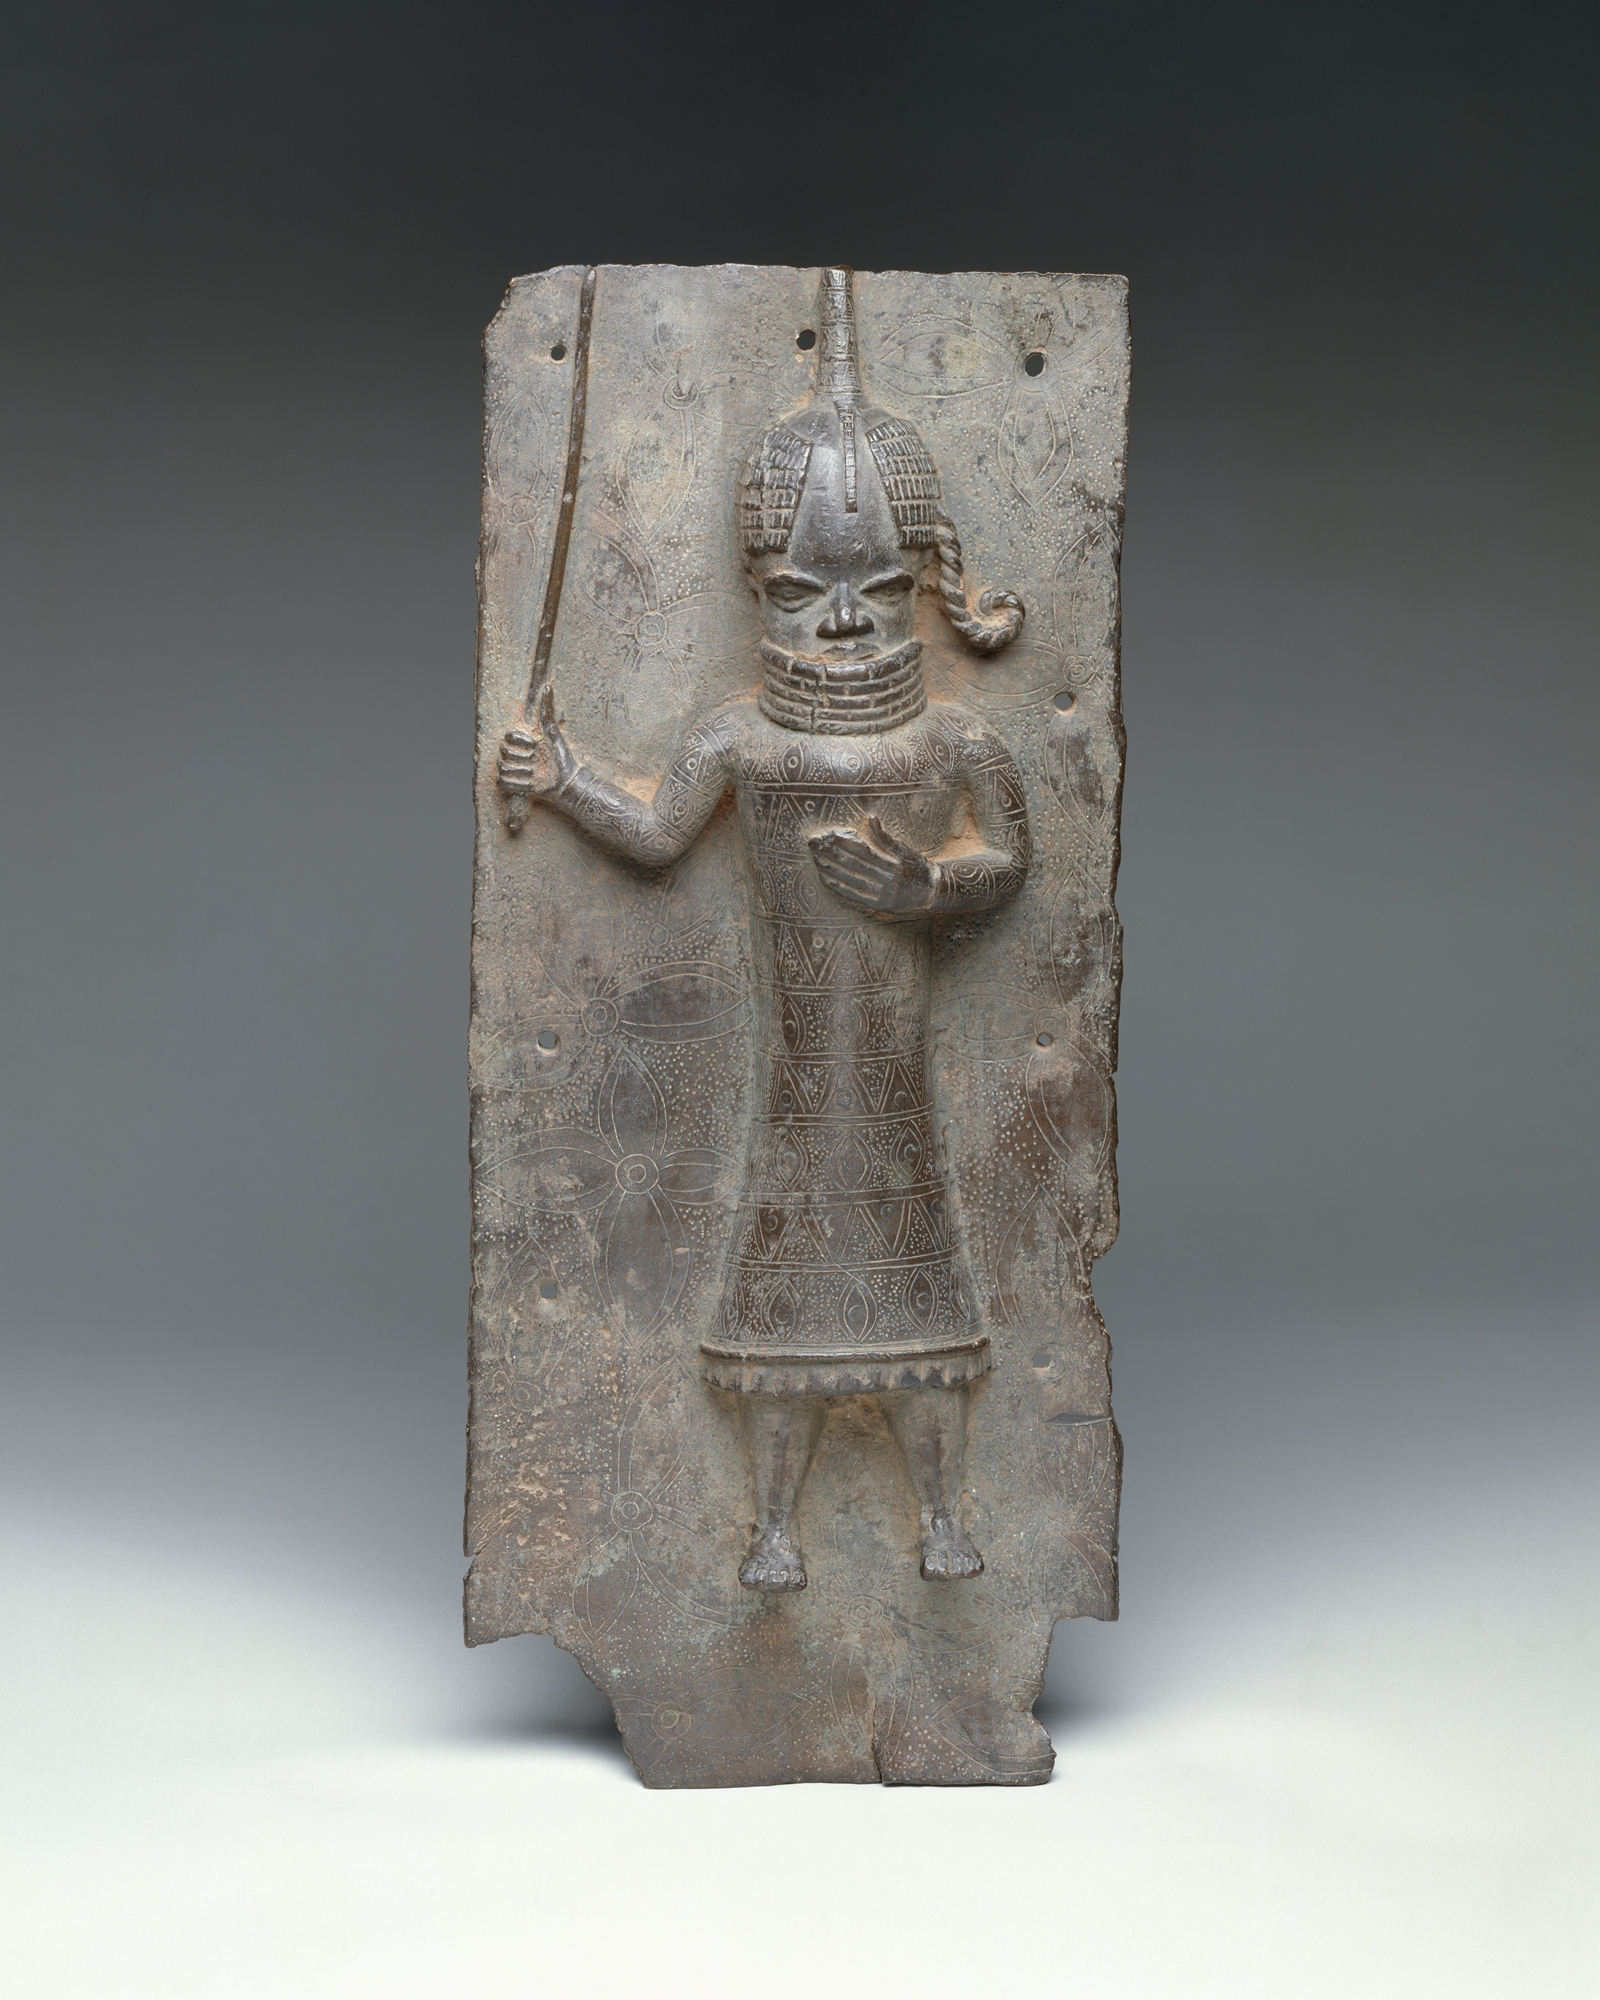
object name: plaque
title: Plaque with Ọ́lọ̀tọ̀n priest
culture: edo period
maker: ìgùn ẹ́rọ̀nwwọ̀n (brass-casting guild) artists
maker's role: artist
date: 1540-1570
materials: brass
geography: nigeria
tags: men